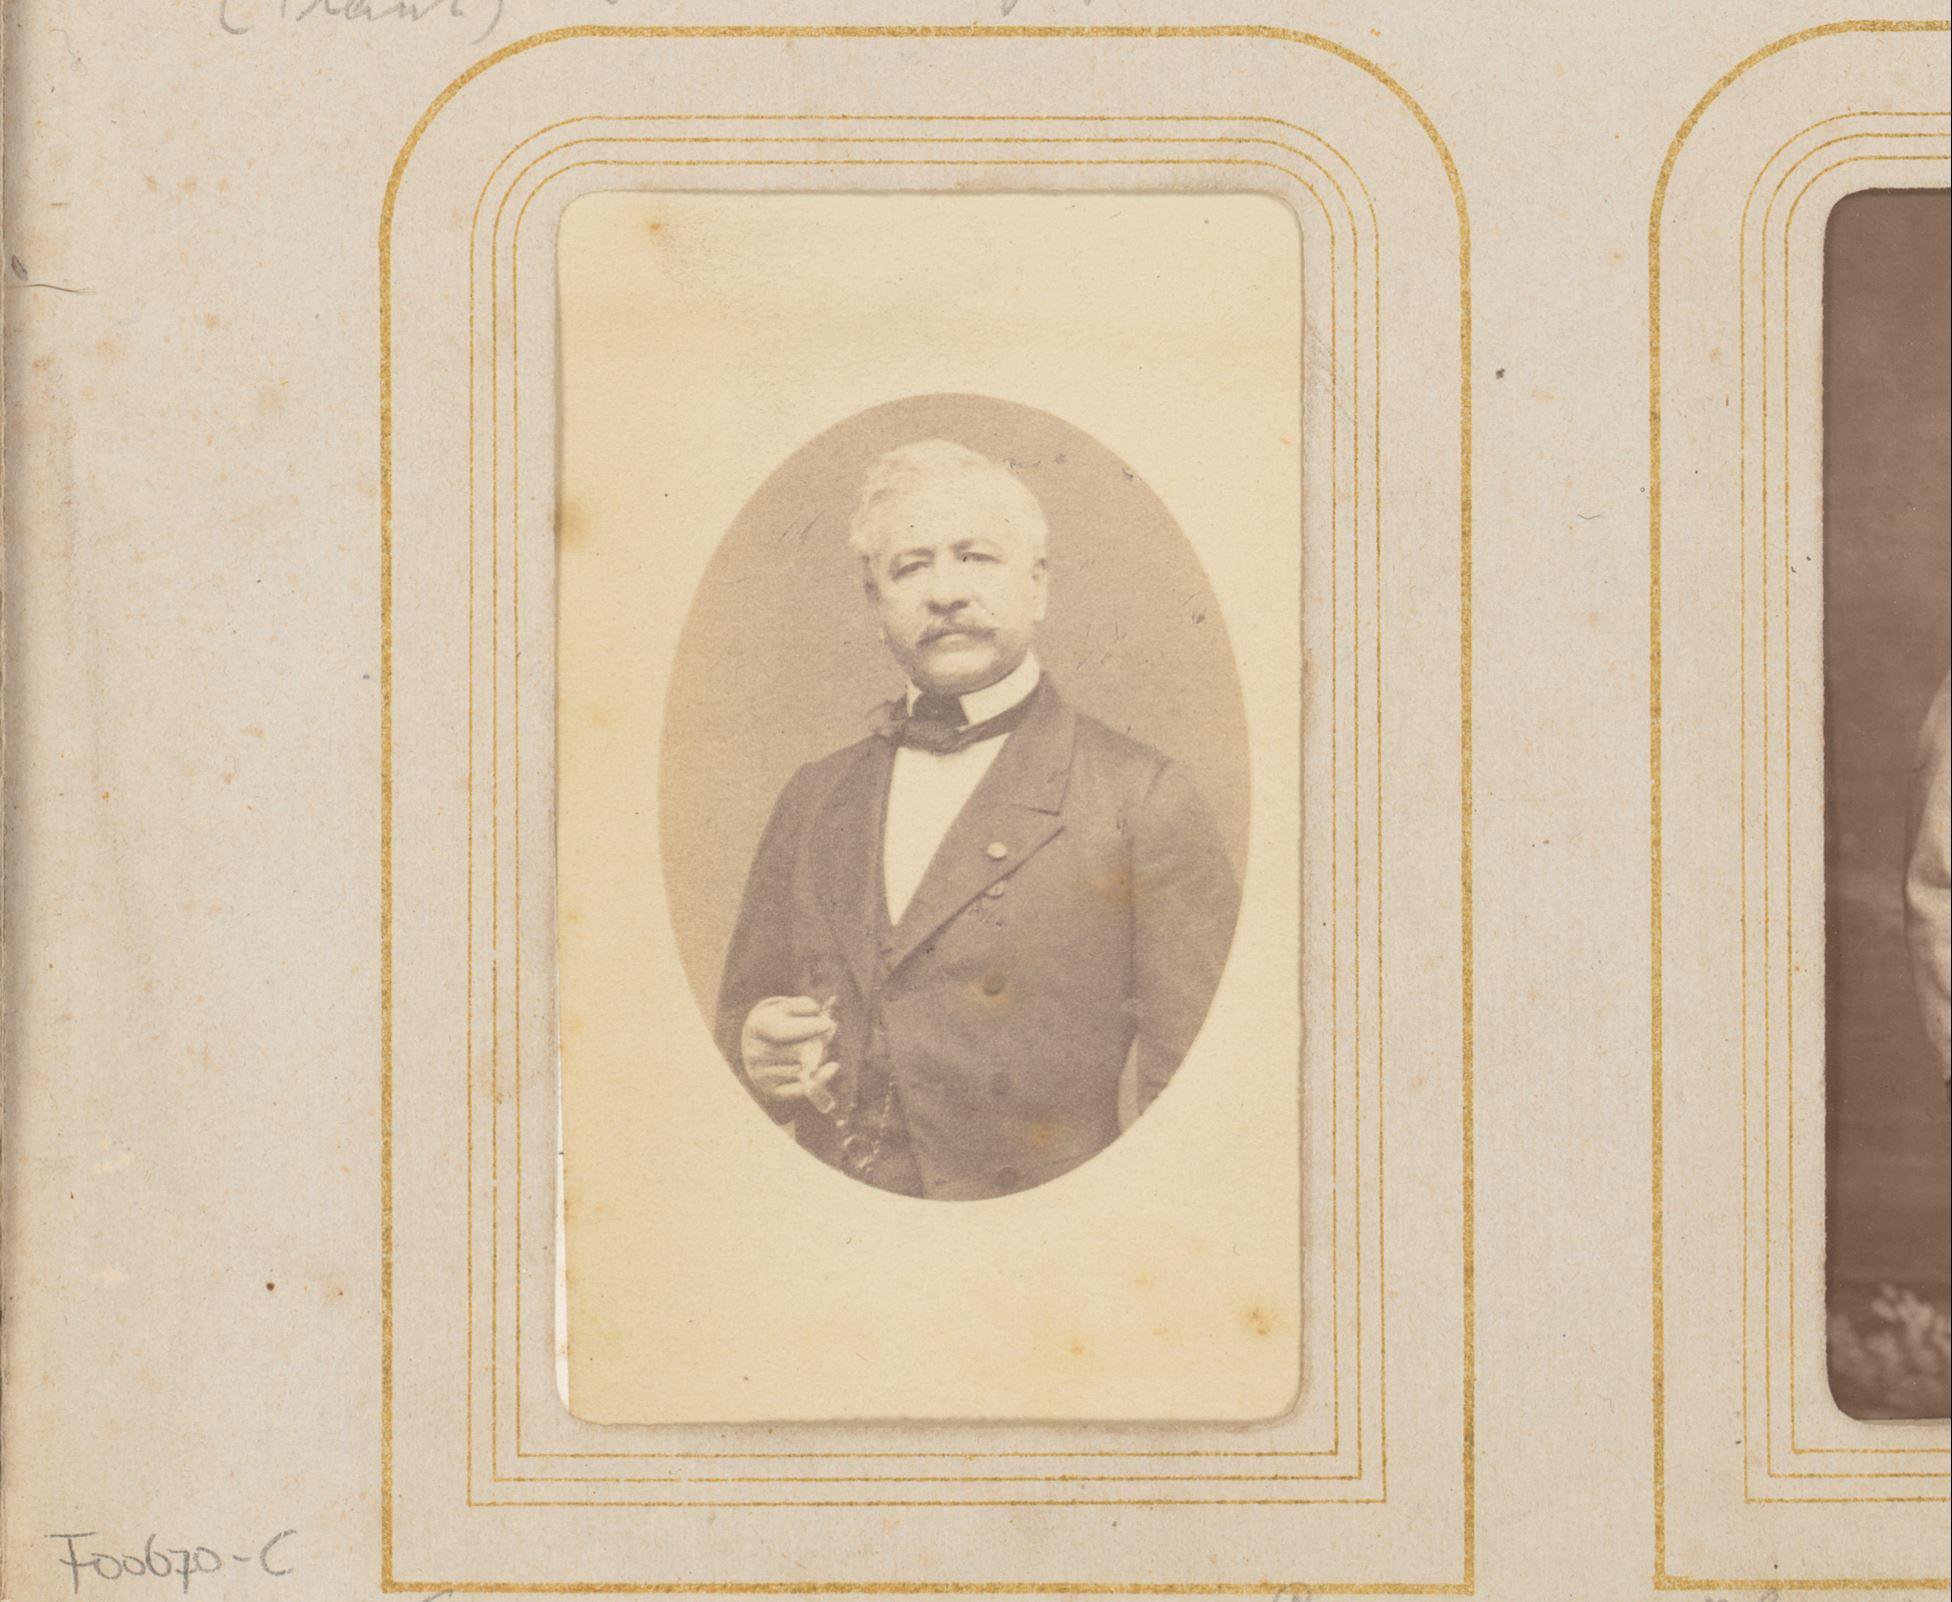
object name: carte de visite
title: Portret van Ferdinand de Lesseps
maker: georges mathurin legé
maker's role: fotograaf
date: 1860-1875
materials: cardboard, photographic support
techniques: albumen print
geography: paris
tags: france, engineer, historical persons, diplomacy, diplomat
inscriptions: annotation: ‘Ferdinand vicomte de Lesseps/ fr. ingenieur 1805 - 1894/ (Legé-Carjat)’